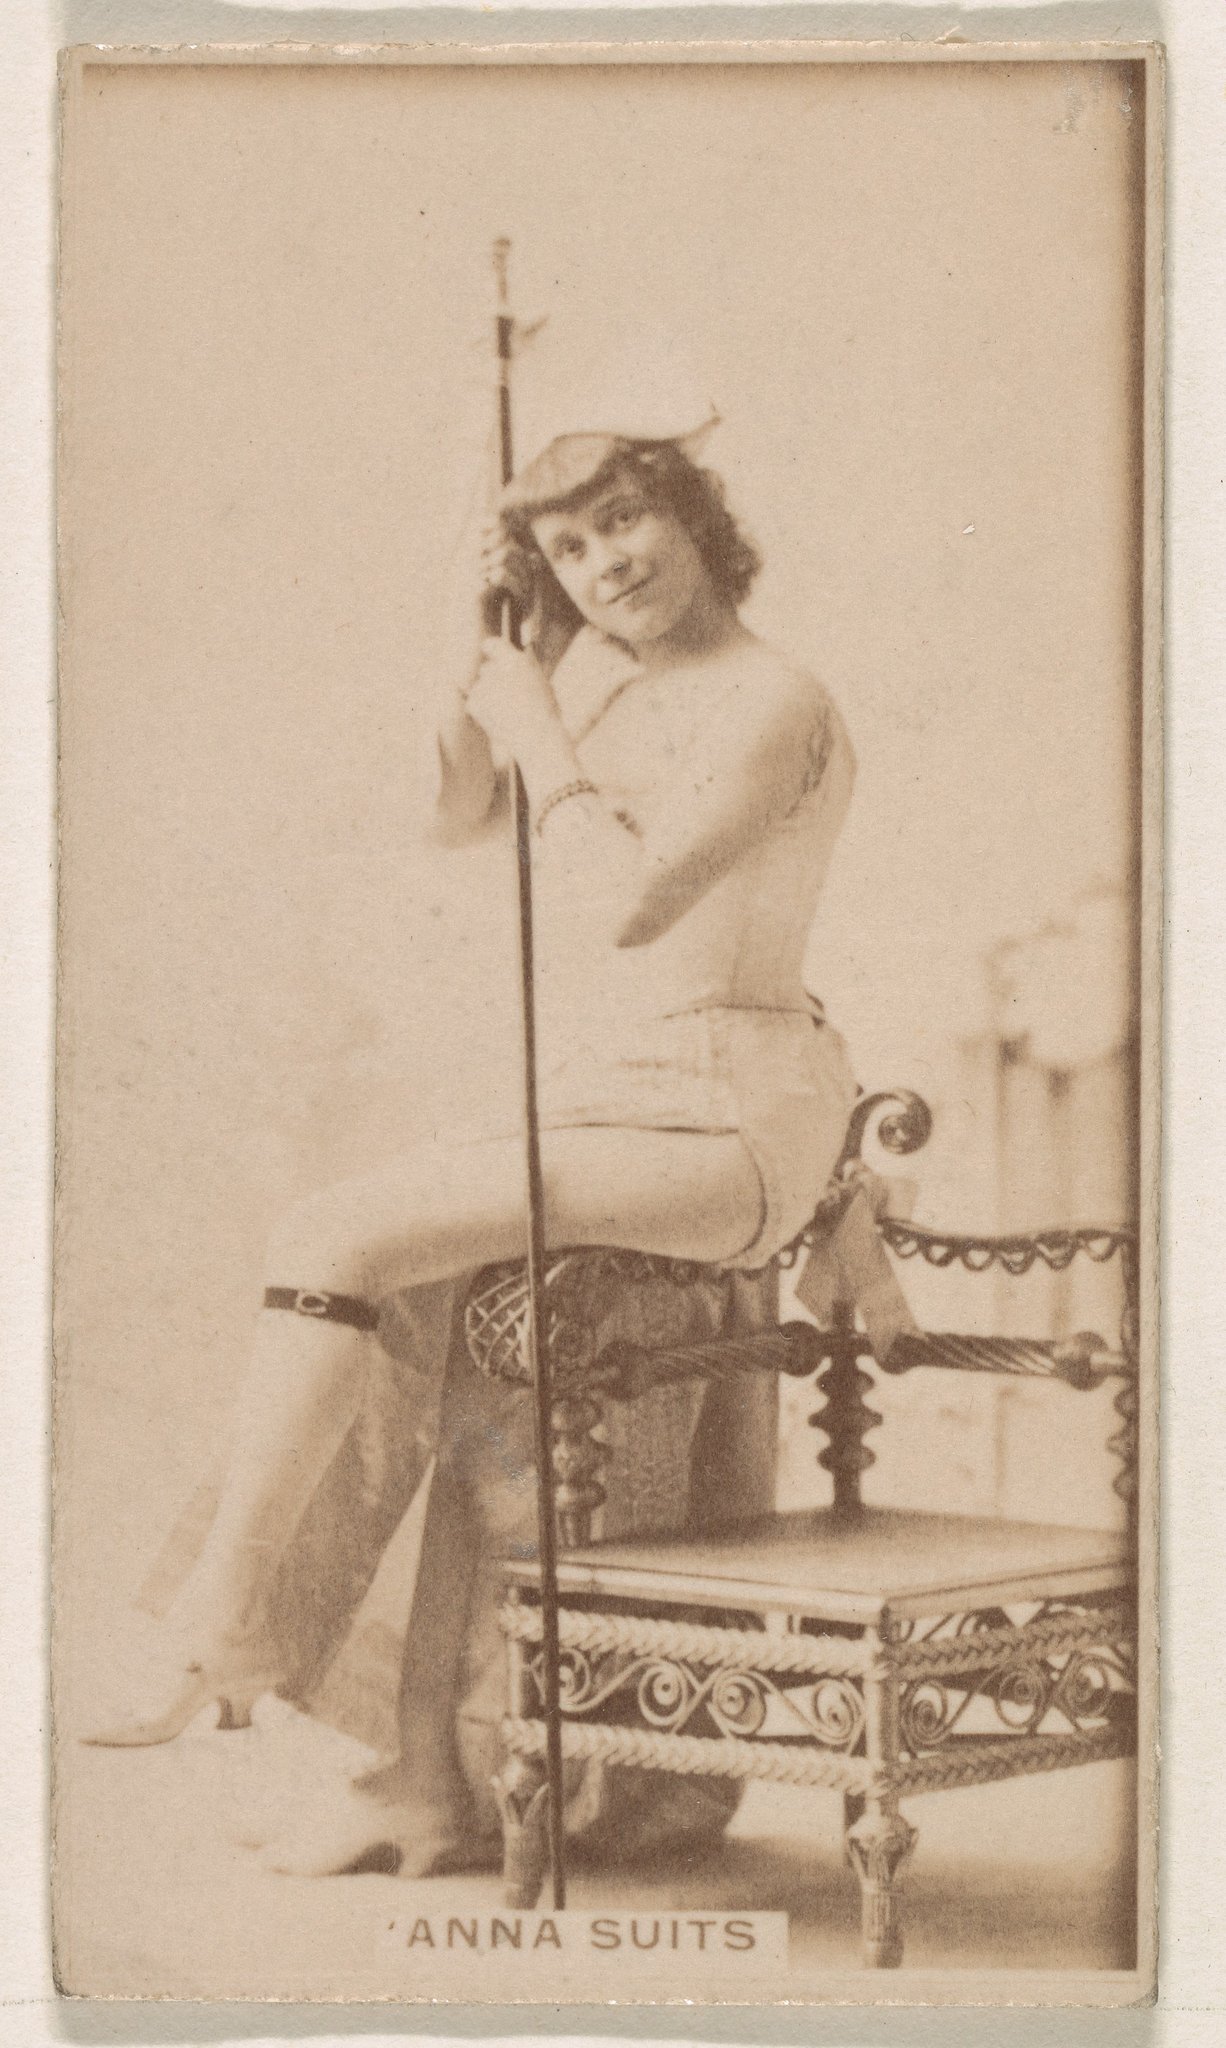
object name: photograph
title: Anna Suits, from the Actresses series (N245) issued by Kinney Brothers to promote Sweet Caporal Cigarettes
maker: kinney brothers tobacco company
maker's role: publisher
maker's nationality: american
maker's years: 1869-2011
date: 1890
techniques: albumen silver print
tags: portraits,women,actresses